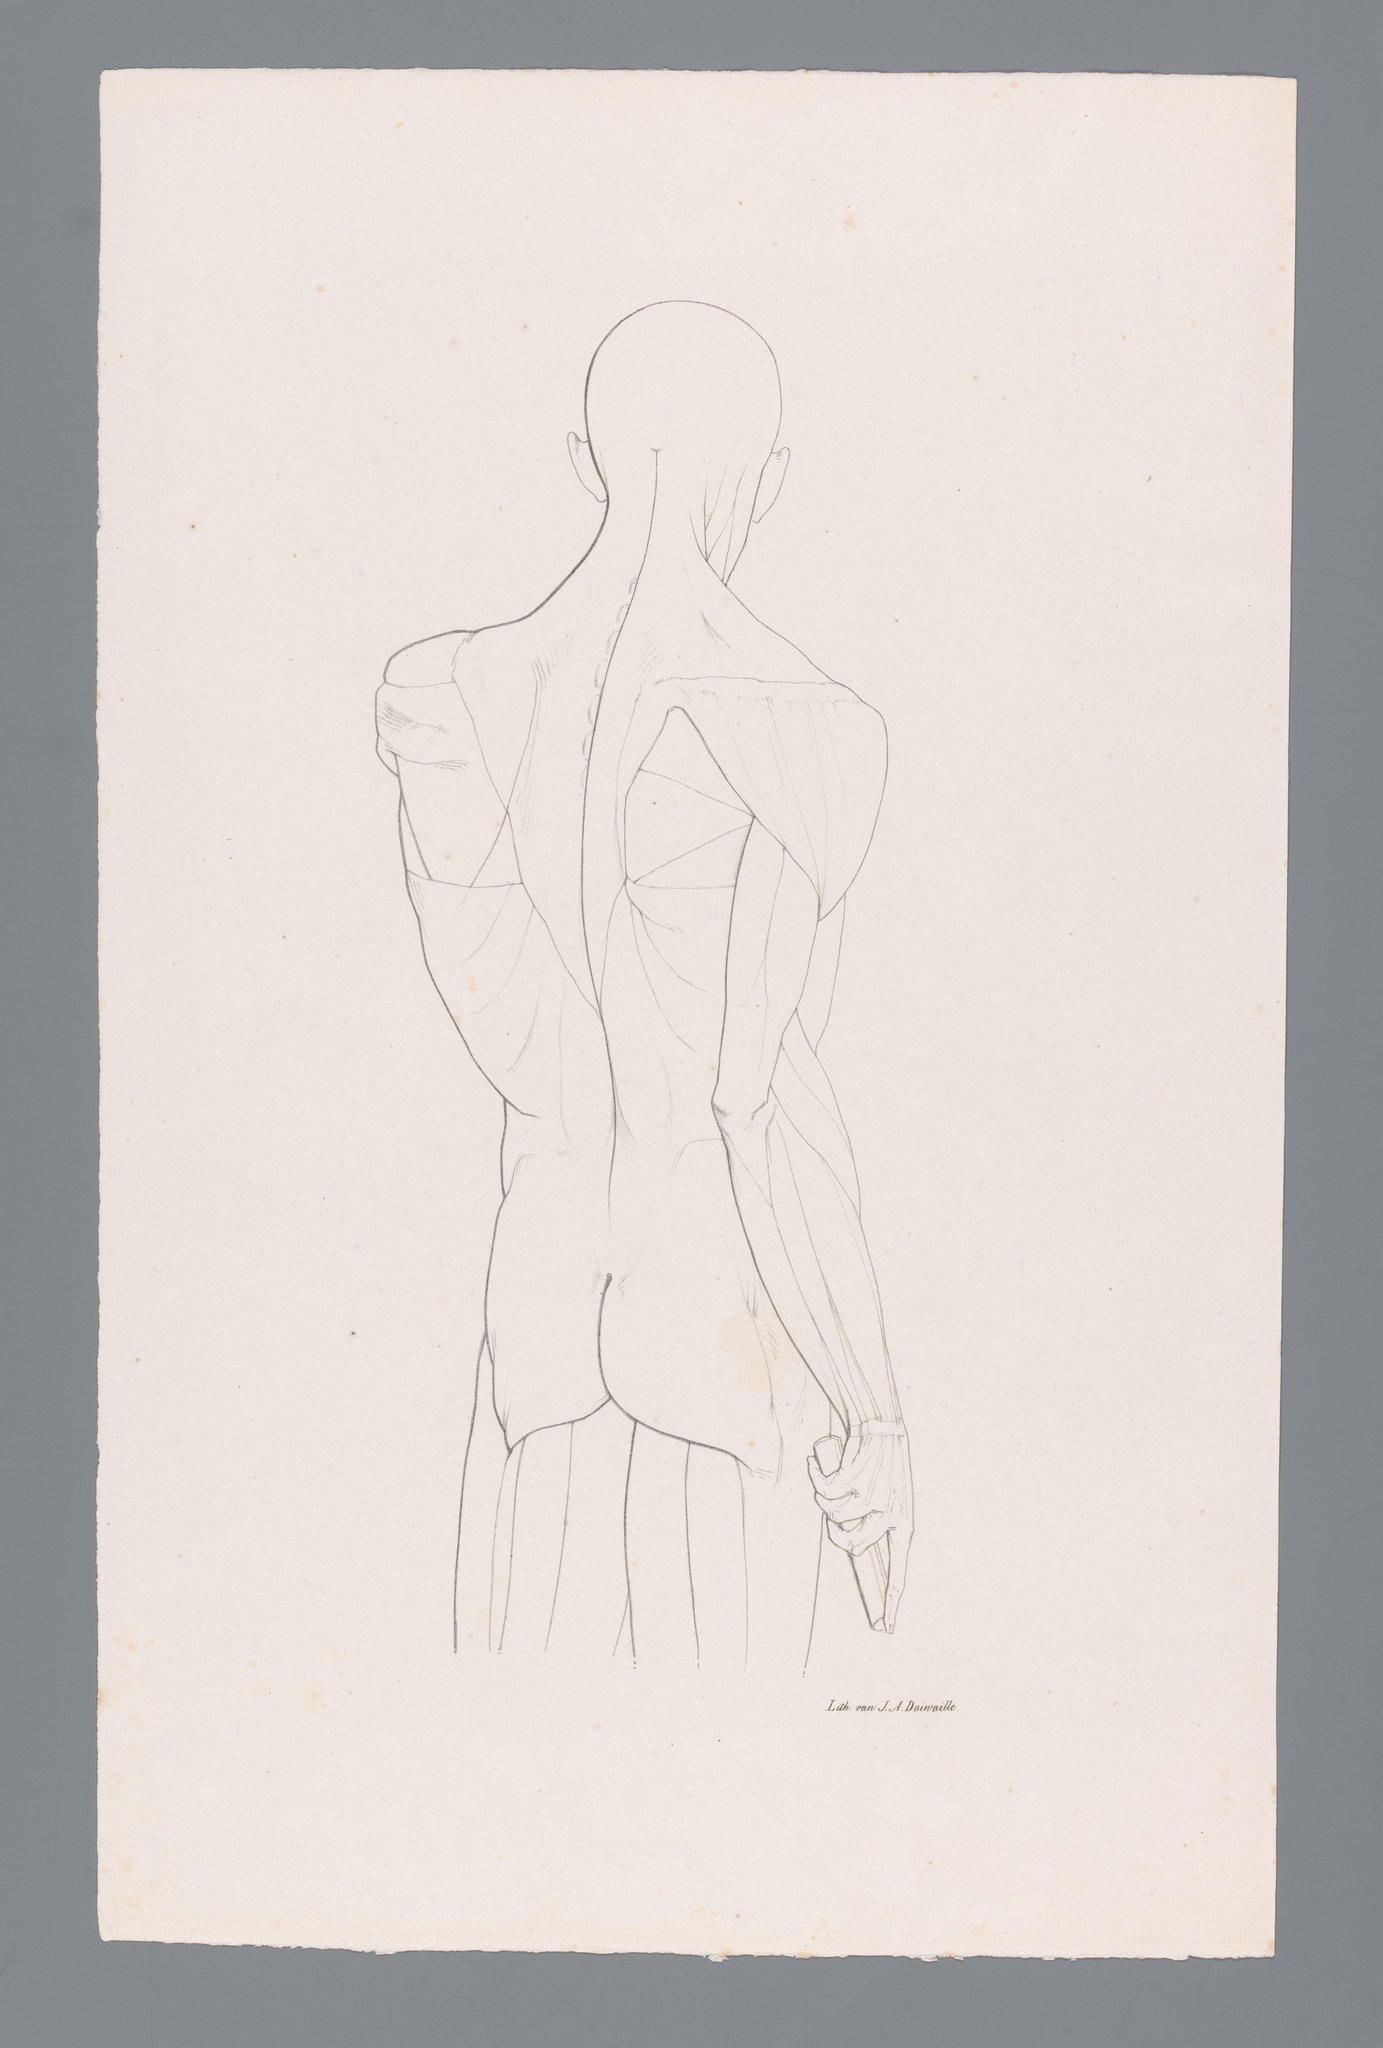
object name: print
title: Anatomie-studien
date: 1828-1830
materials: paper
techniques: lithograph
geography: amsterdam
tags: back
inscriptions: watermark, collector's mark: Lugt 2228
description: Onderdeel van een omslag met in totaal achttien anatomische voorstellingen.